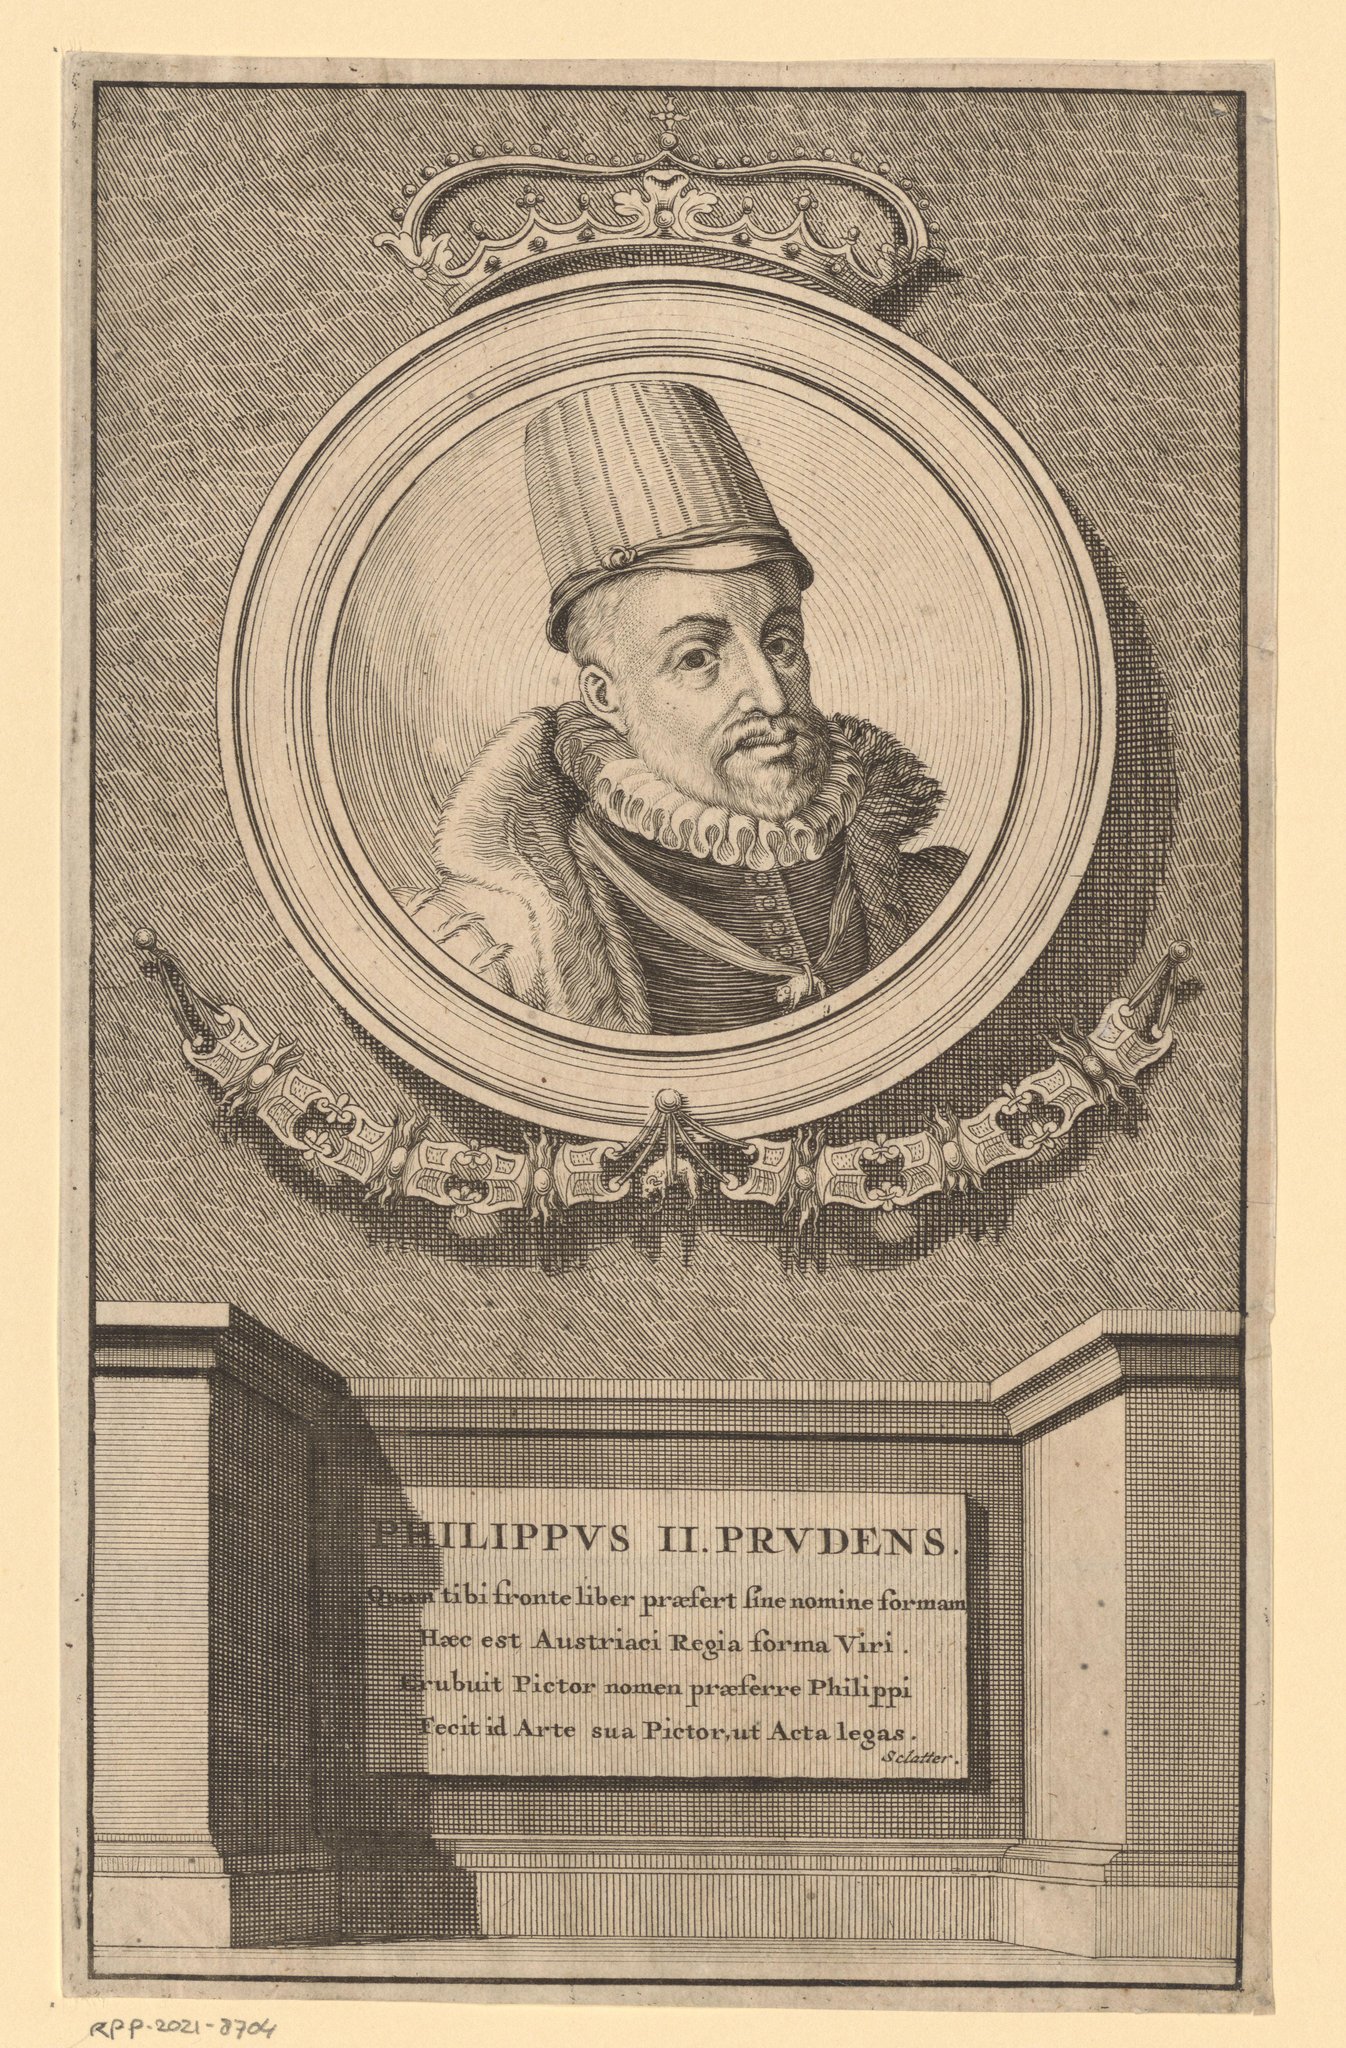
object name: print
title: Principum et illustrium quorundam virorum qui in Europa alibique terrarum quam fama quam eruditione celebres fuerunt, verae imagines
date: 1710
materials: paper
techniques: engraving, etching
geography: leiden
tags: philip ii of spain, adult man, historical persons, knighthood order of the golden fleece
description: Prent uit de serie: Principum et illustrium quorundam virorum qui in Europa alibique terrarum quam fama quam eruditione celebres fuerunt, verae imagines. Leiden: Pieter van der Aa, [1710]. Andere staat gebruikt in: Thesaurus antiquitatum et historiarum Italiae (...). Leiden: Pieter van der Aa, 1704.